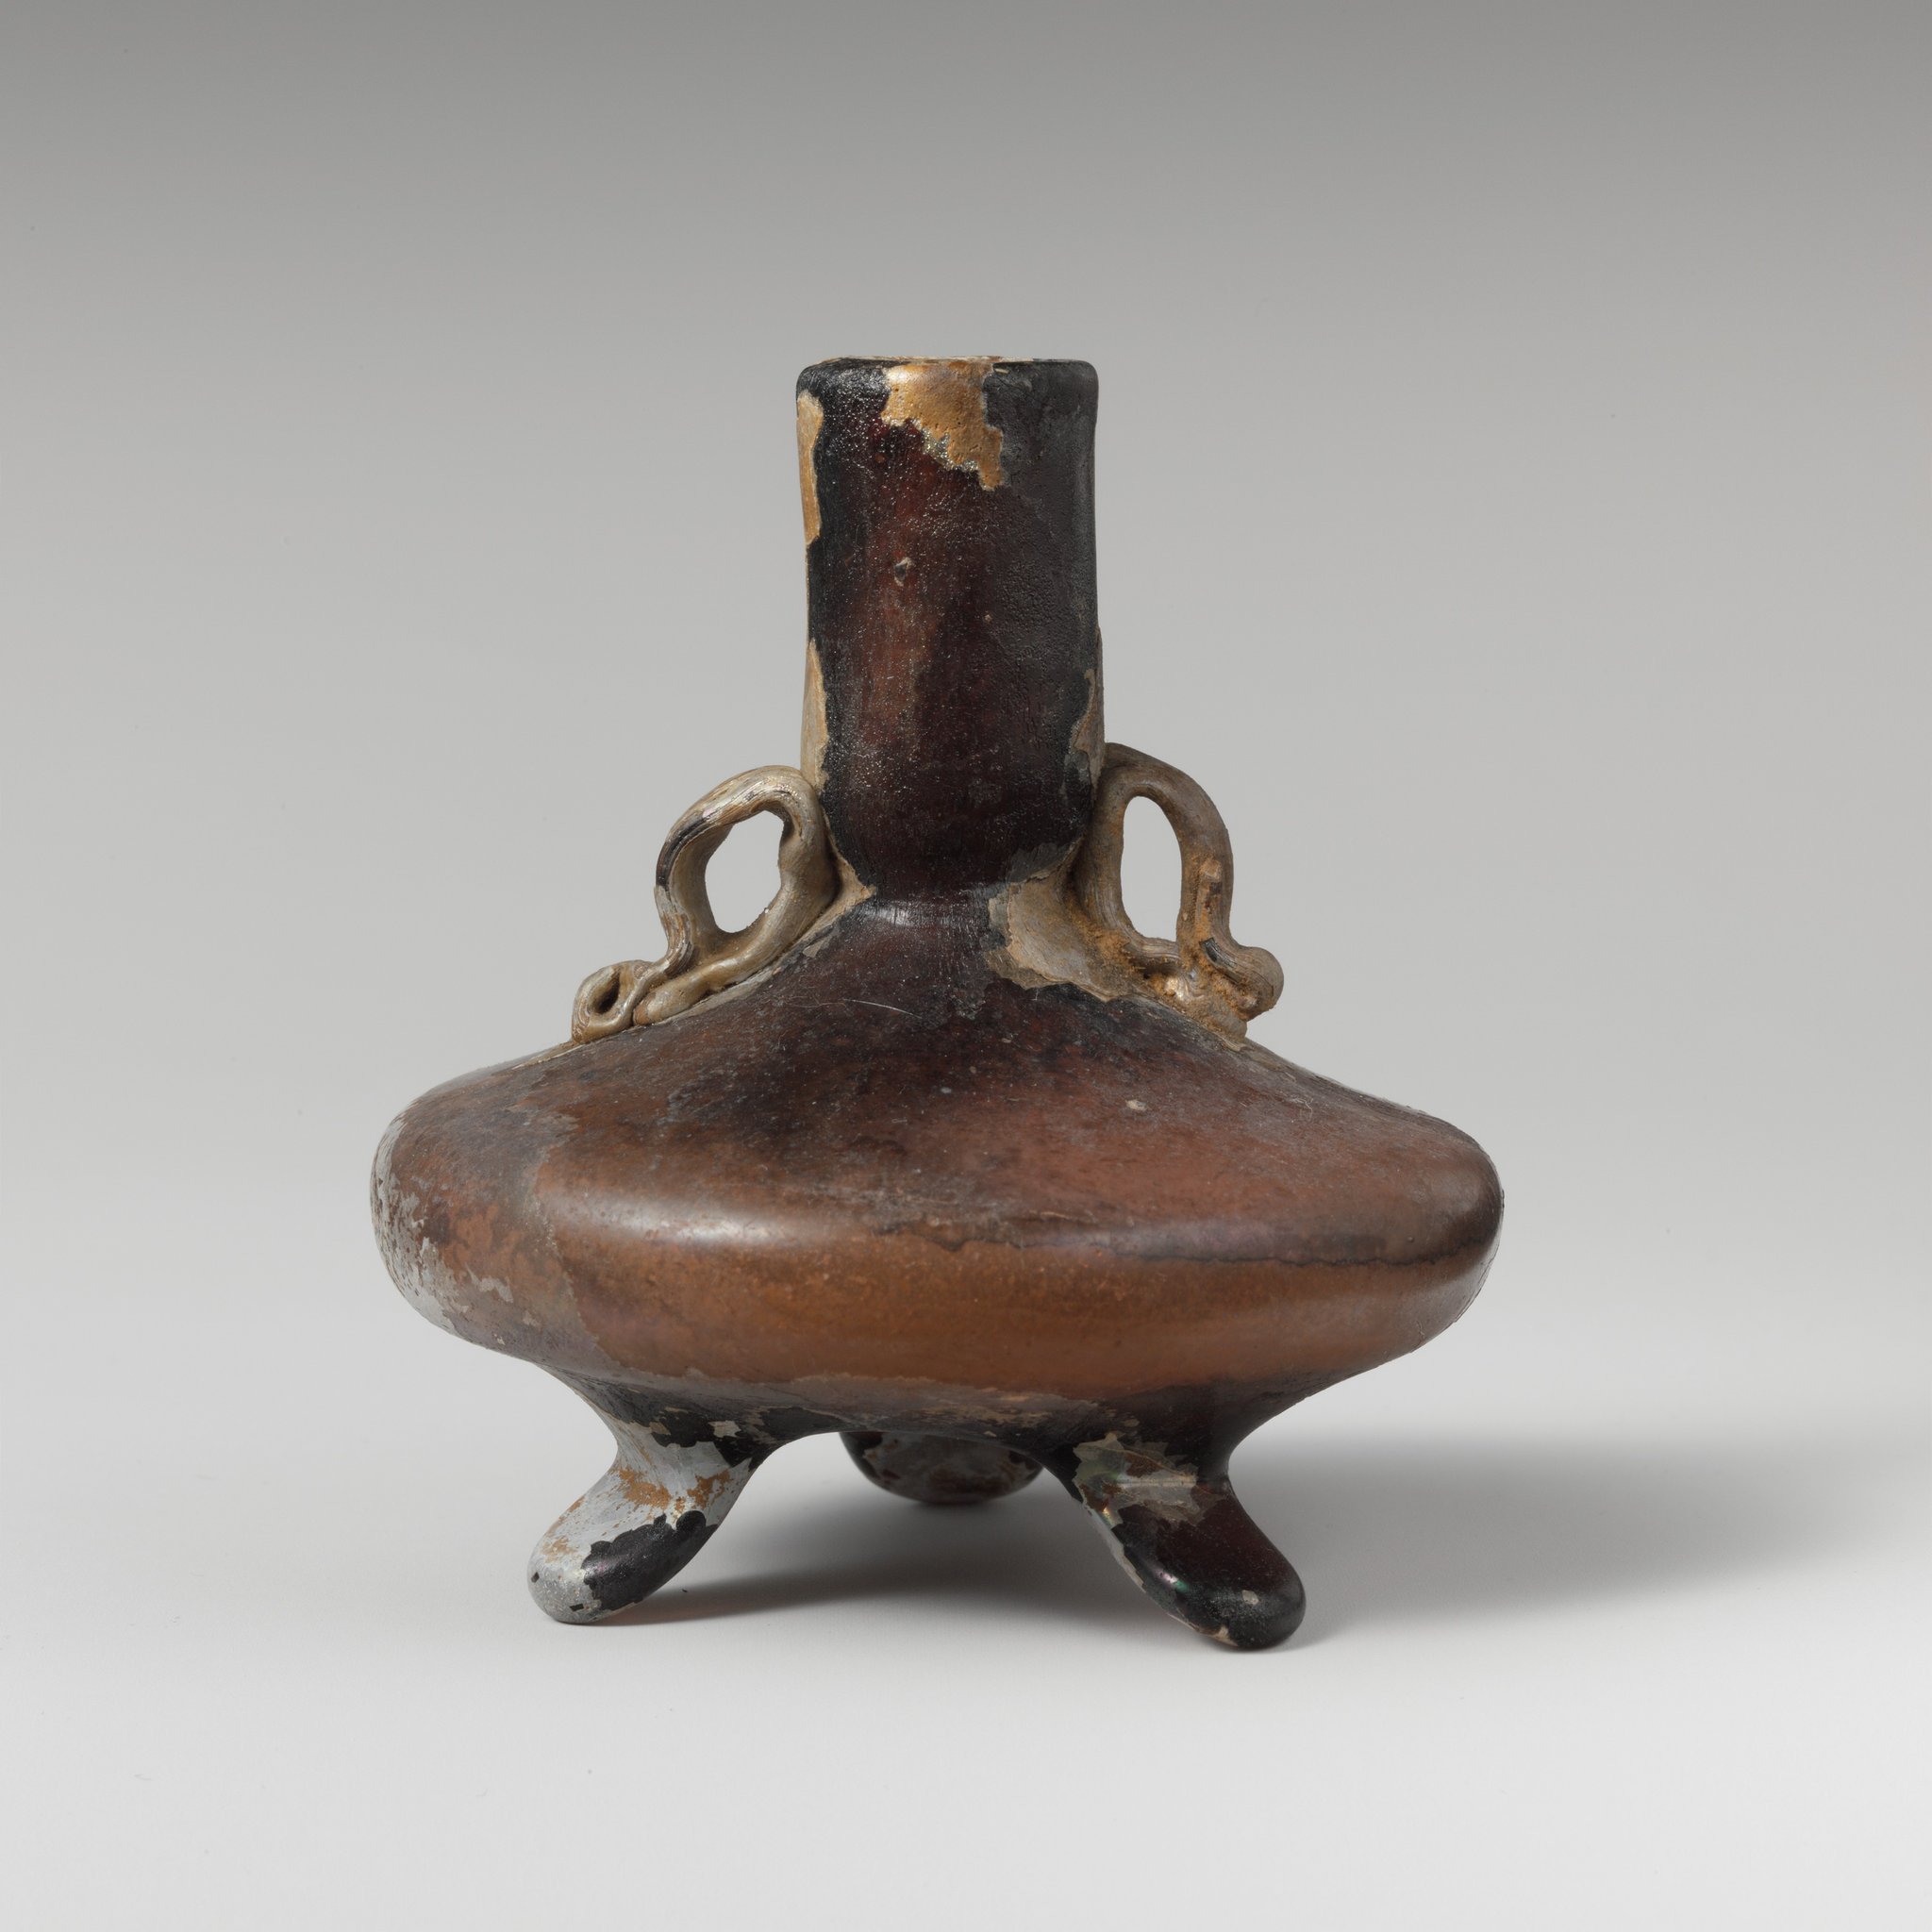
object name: bottle with three foot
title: Glass bottle with three feet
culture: roman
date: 301-400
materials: glass